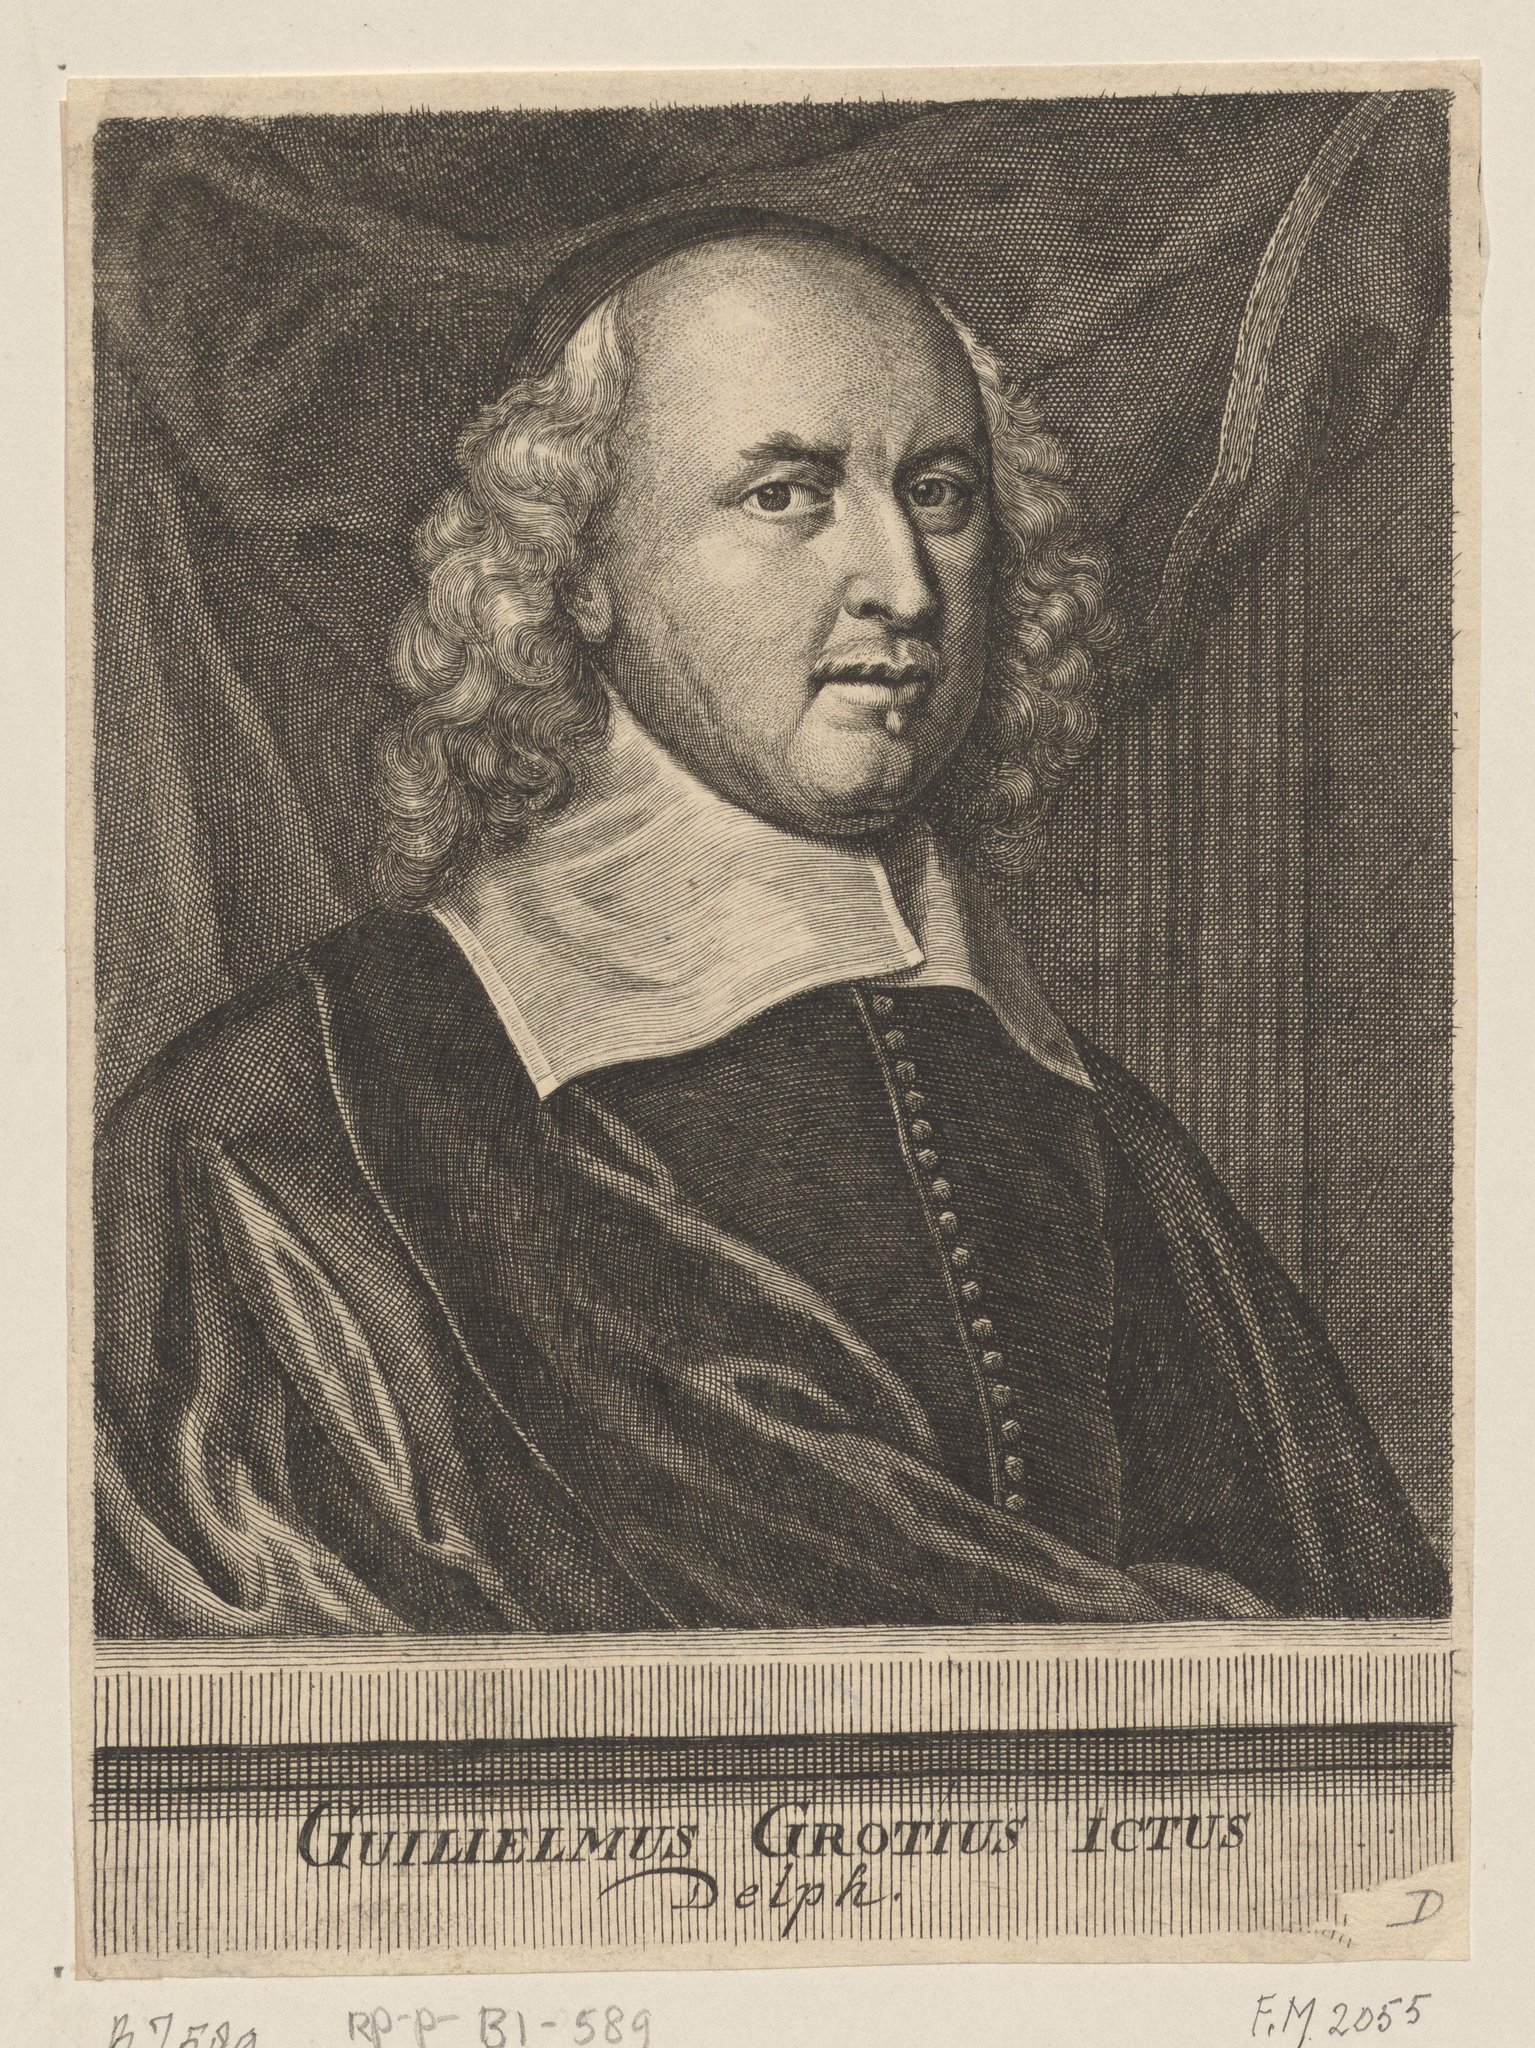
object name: print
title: Portret van Pieter de Groot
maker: Anonymous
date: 1650-1750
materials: paper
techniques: engraving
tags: historical persons, lawyer, attorney at law, portrait of a writer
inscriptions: collector's mark: Lugt 2228